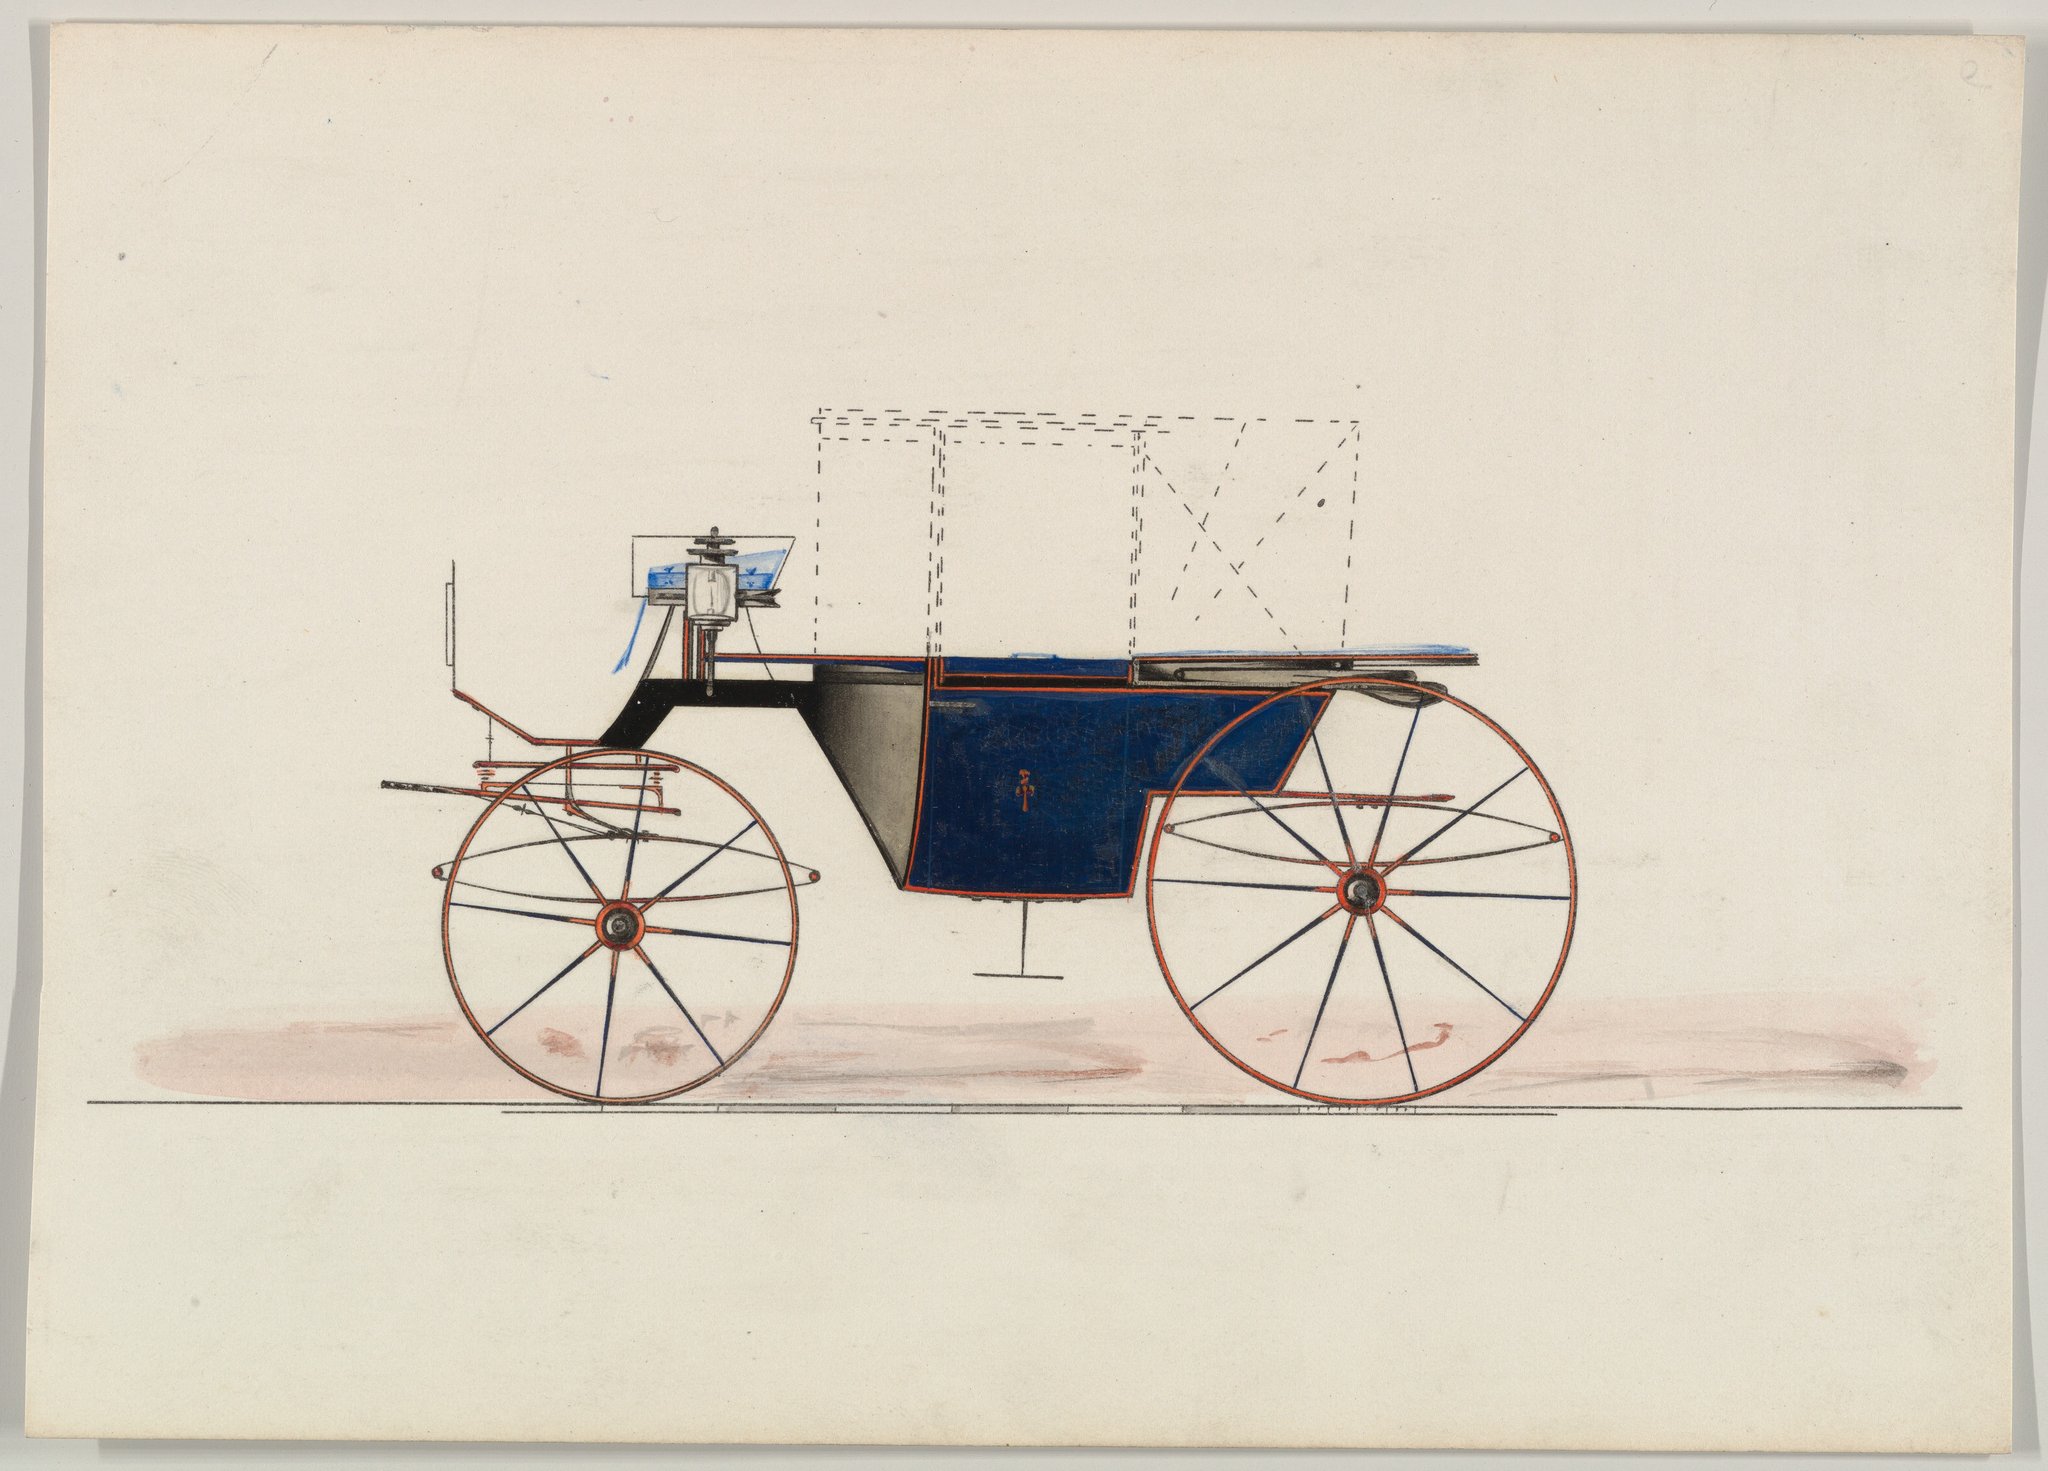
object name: drawing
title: Design for Double Front Landaulet (unnumbered)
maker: brewster & co.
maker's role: manufacturer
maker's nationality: american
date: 1850-1870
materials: gouache, gum arabic, ink, watercolor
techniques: pen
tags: carriages